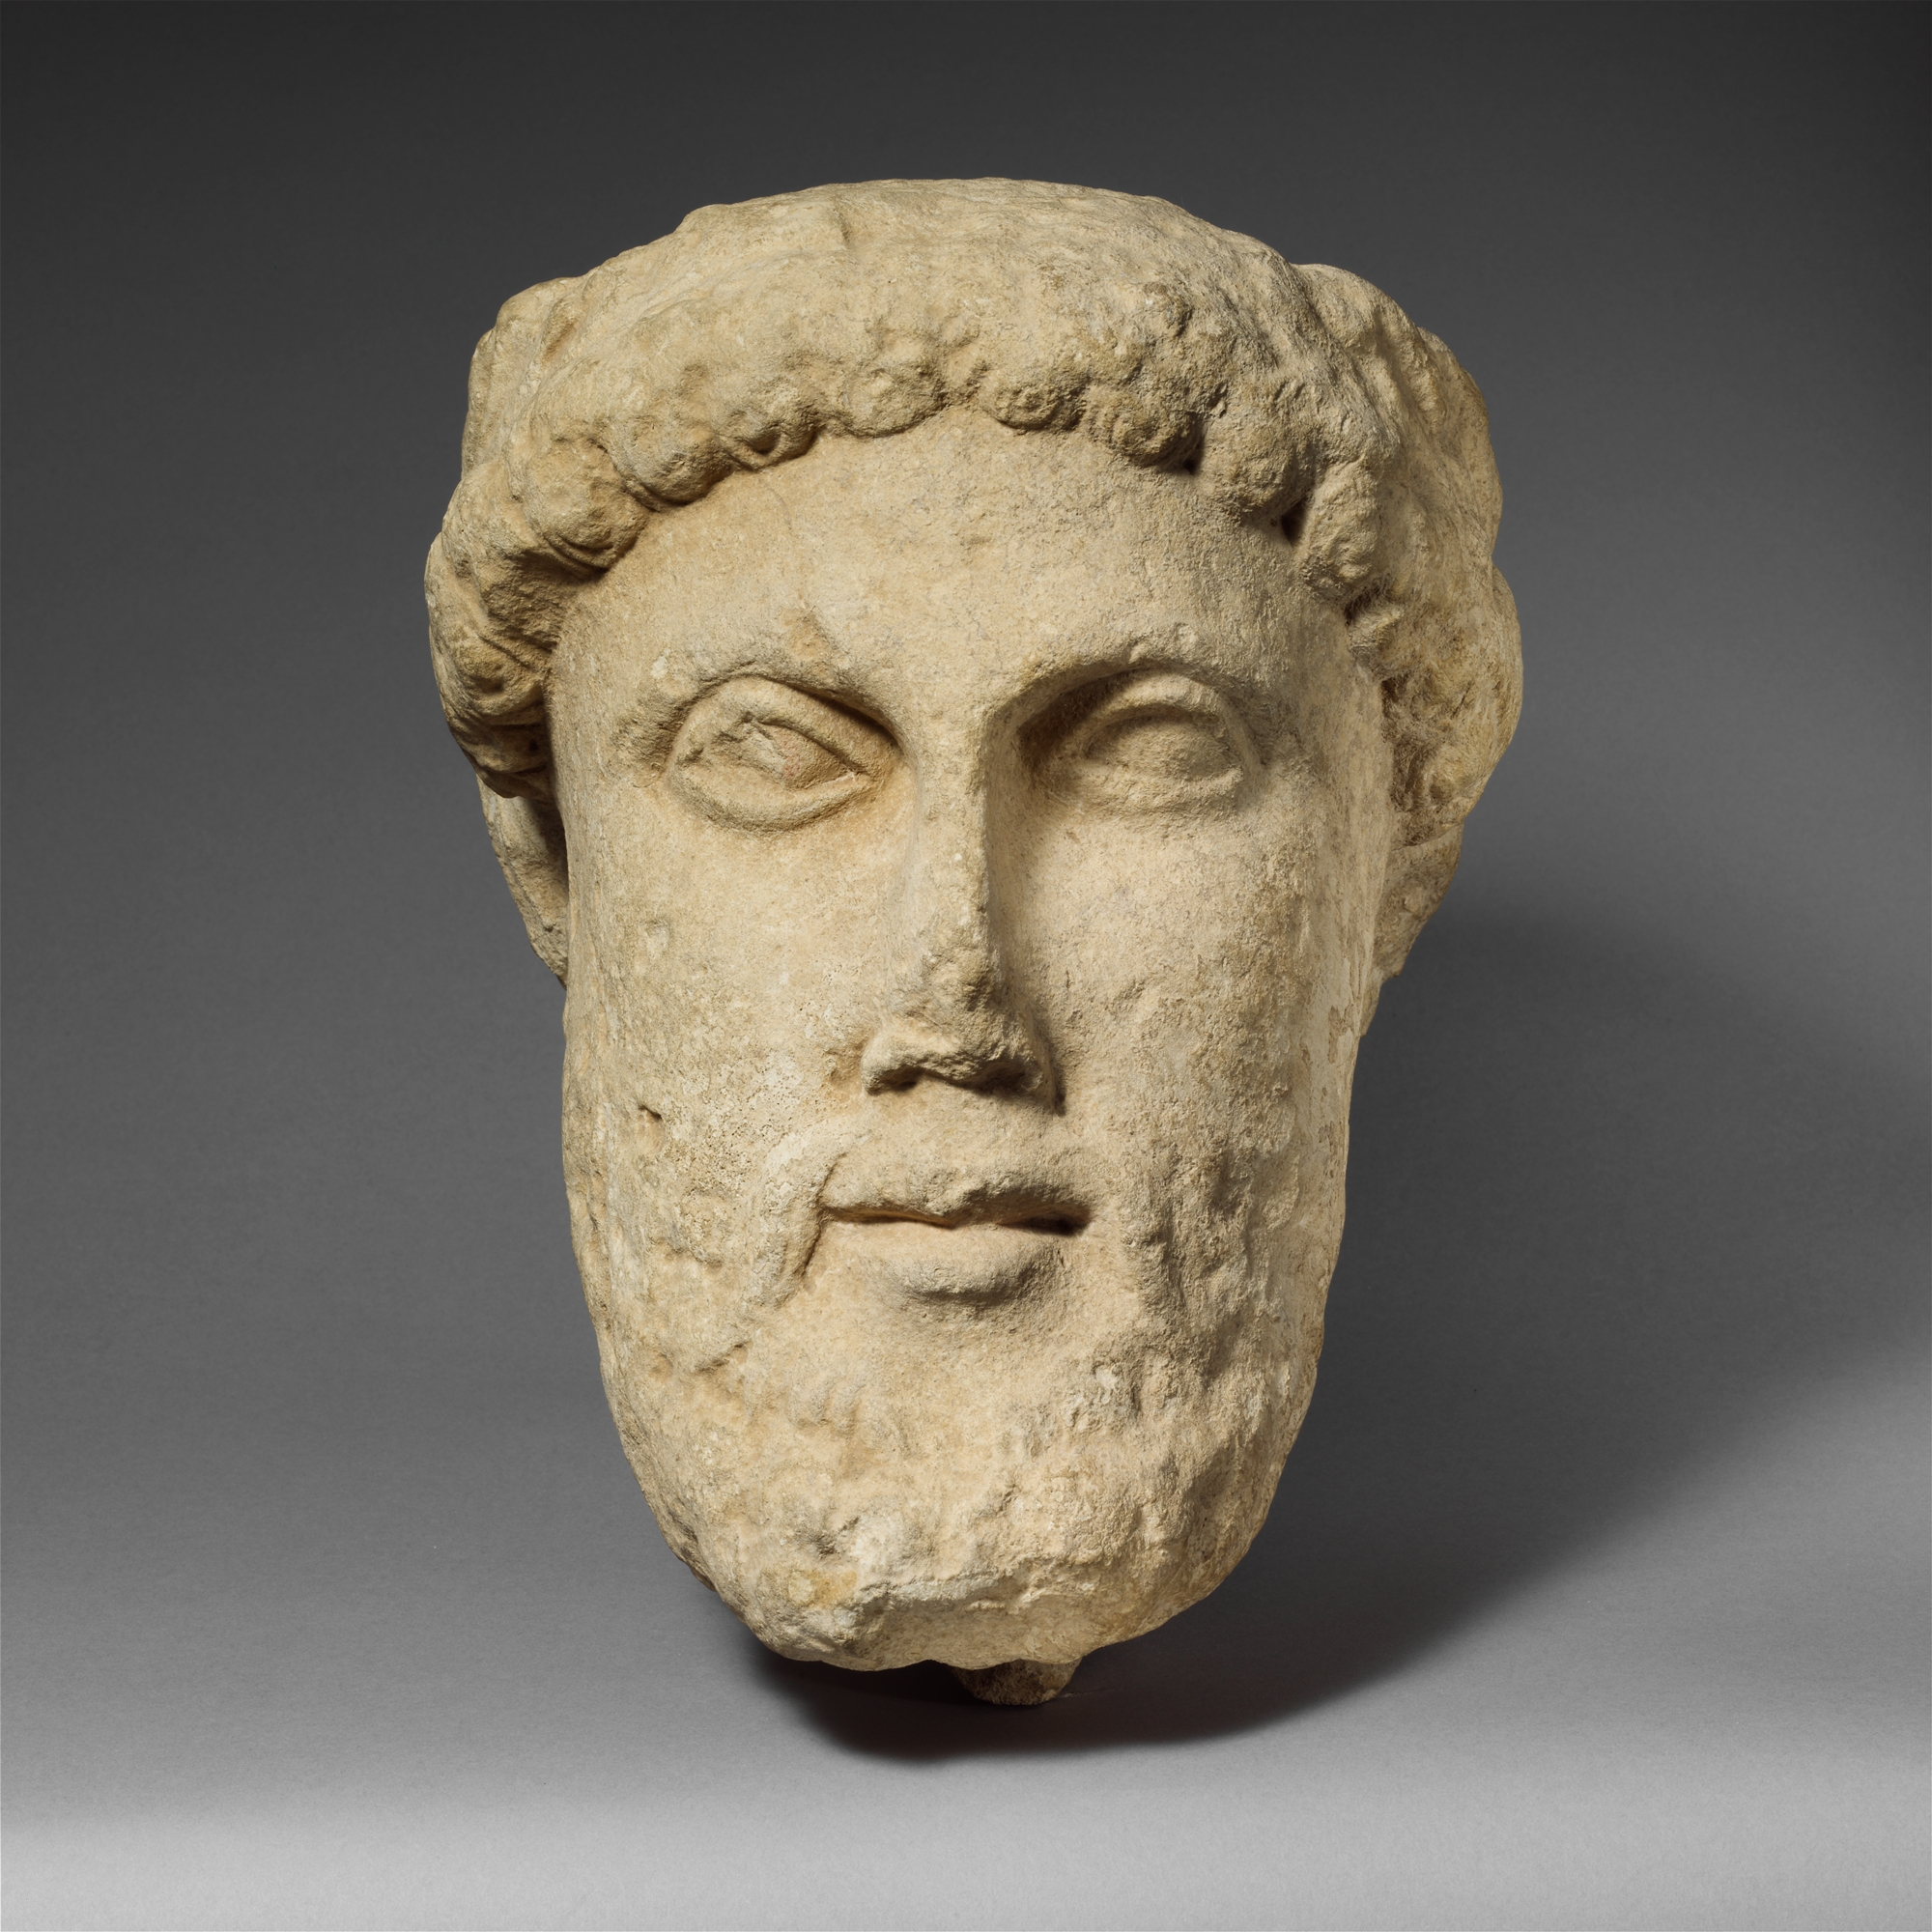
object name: head of a man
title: Limestone head of a bearded male with a wreath of leaves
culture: cypriot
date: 434-401 BCE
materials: limestone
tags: heads,men,wreaths